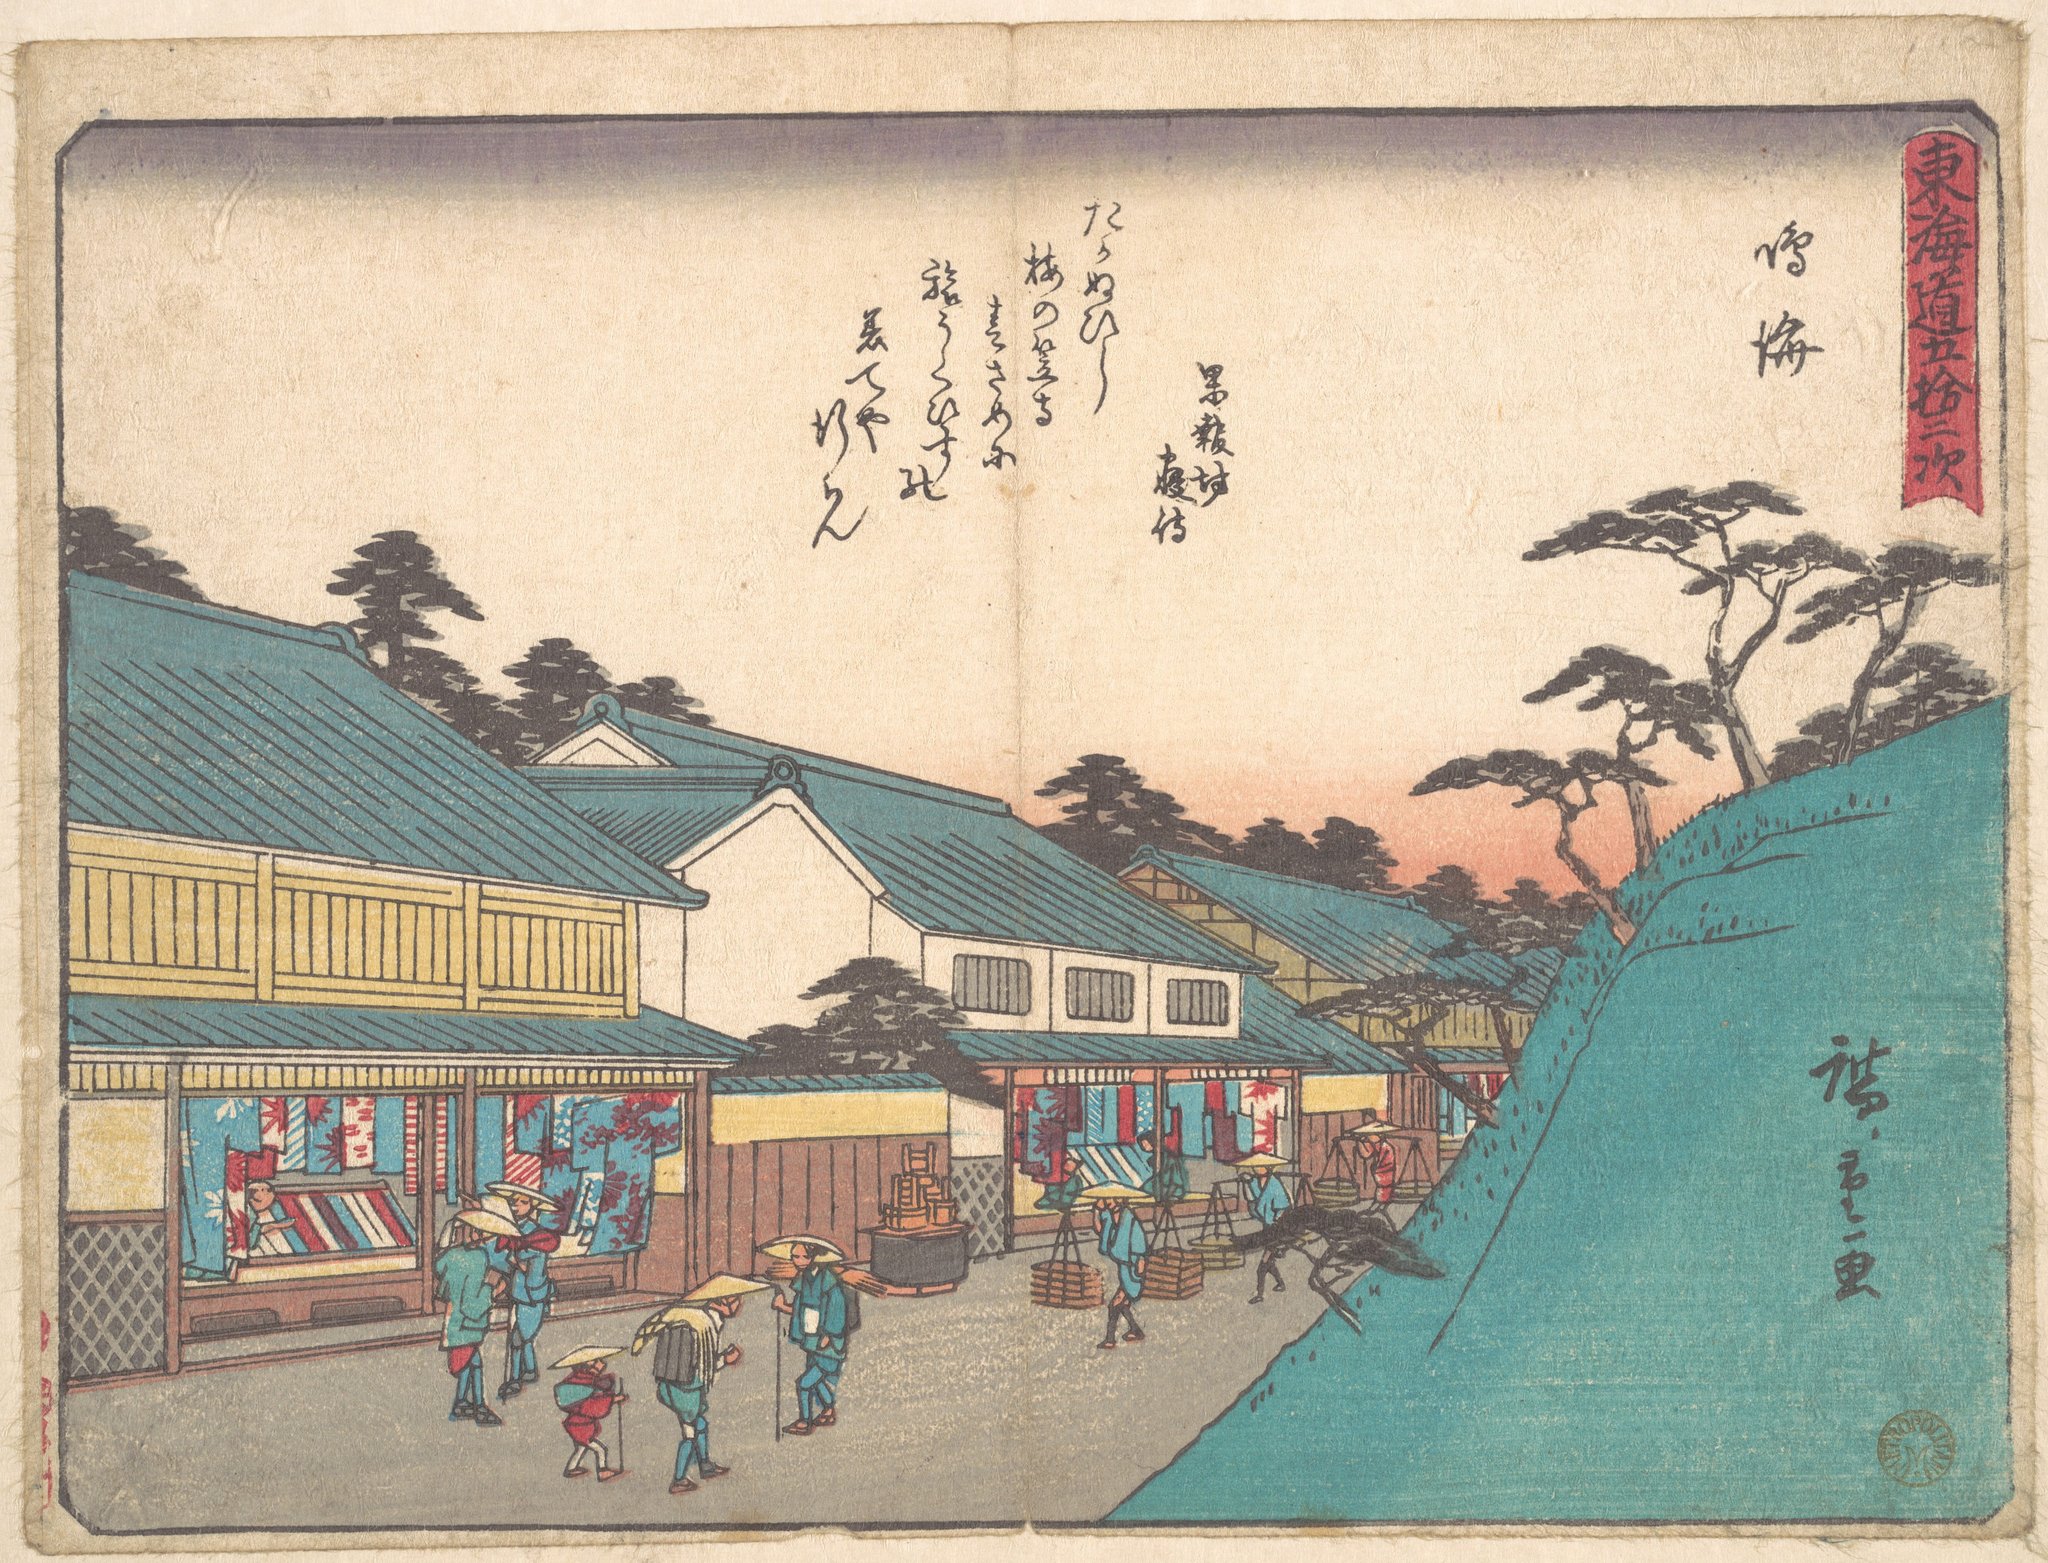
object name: print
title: Narumi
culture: japanese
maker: utagawa hiroshige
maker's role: artist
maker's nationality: japanese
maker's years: 1797-1858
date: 1838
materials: ink, paper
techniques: woodblock print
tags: human figures,houses,streets,trees